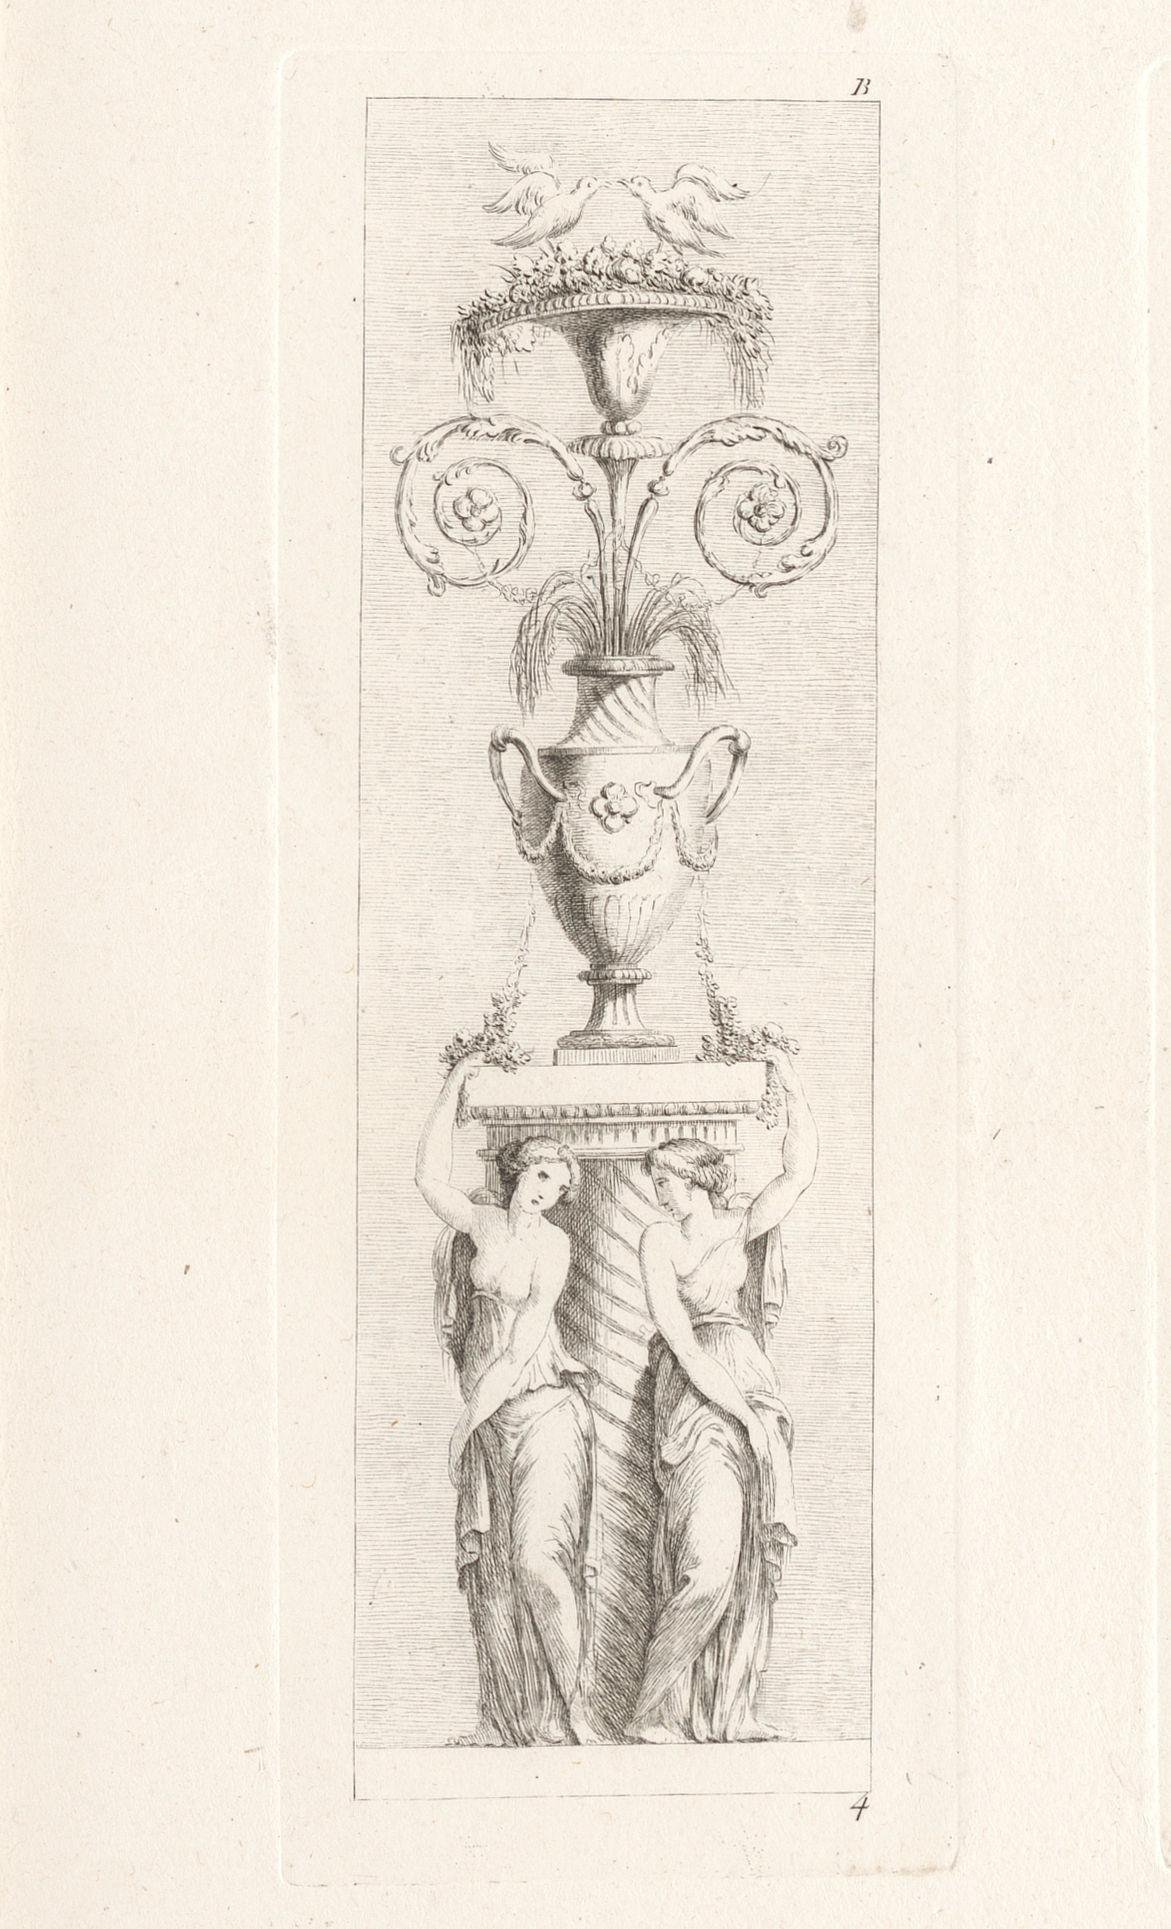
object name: ornament print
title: IIe. cahier d'arabesques par F. Bo.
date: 1802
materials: paper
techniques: etching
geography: paris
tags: adult woman, ornament ~ arabesque, vase ~ ornament, mask, mascaron ~ ornament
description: Doordat dit album bestaat uit meerdere, deels eerder uitgegeven prentreeksen, is de datering niet consequent. Het geheel is op de titelpagina gedateerd op 1802. Deze reeks is niet los gedateerd. De serietitel voor het gehele werk is "Recueil d'arabesques, contenant les loges du Vatican". De andere serietitel is de titel van de specifieke reeks binnen het geheel.